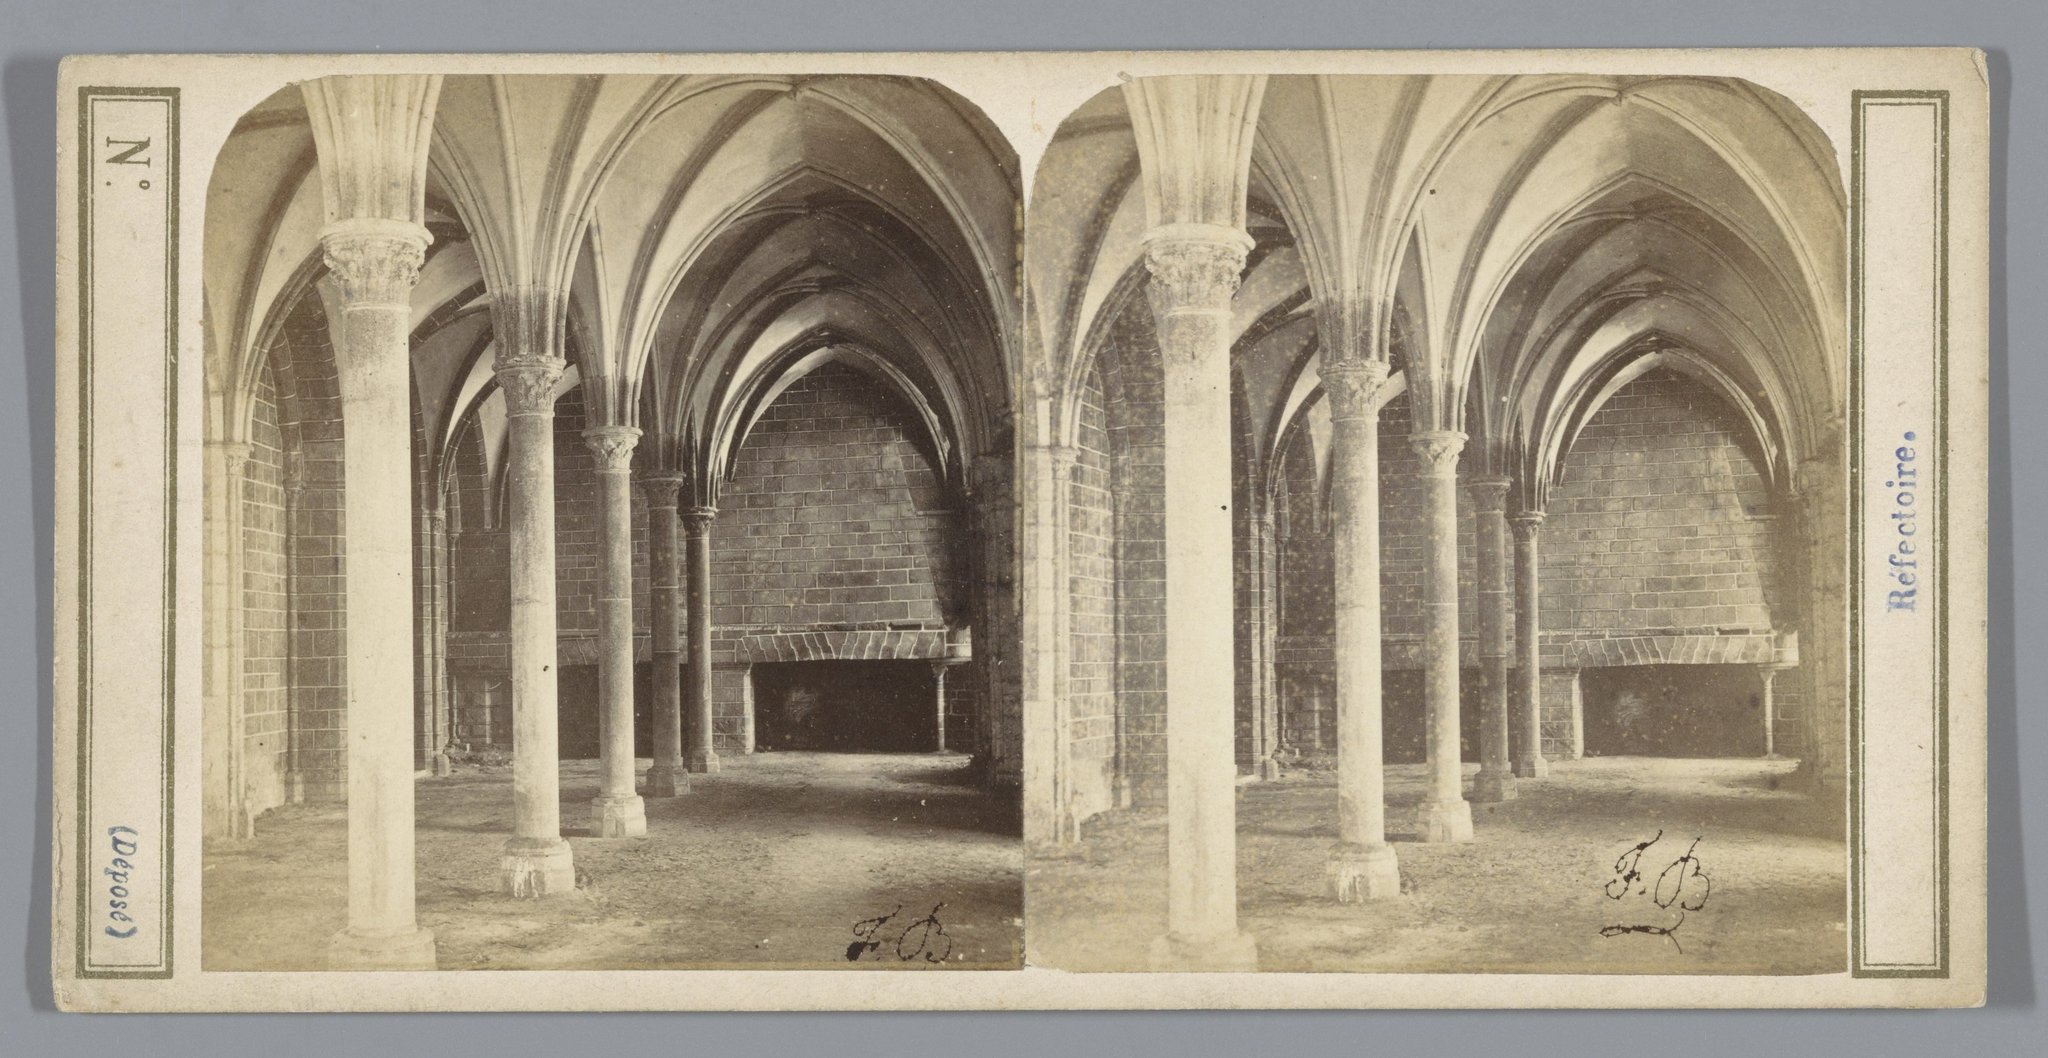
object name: stereograph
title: Refter van de abdij van Mont Saint-Michel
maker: fb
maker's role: fotograaf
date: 1860-1865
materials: cardboard, photographic support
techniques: albumen print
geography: mont-saint-michel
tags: refectory ~ monastery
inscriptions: inscription: ‘Pélerinage du Mont-St.- Michel (Manche)’